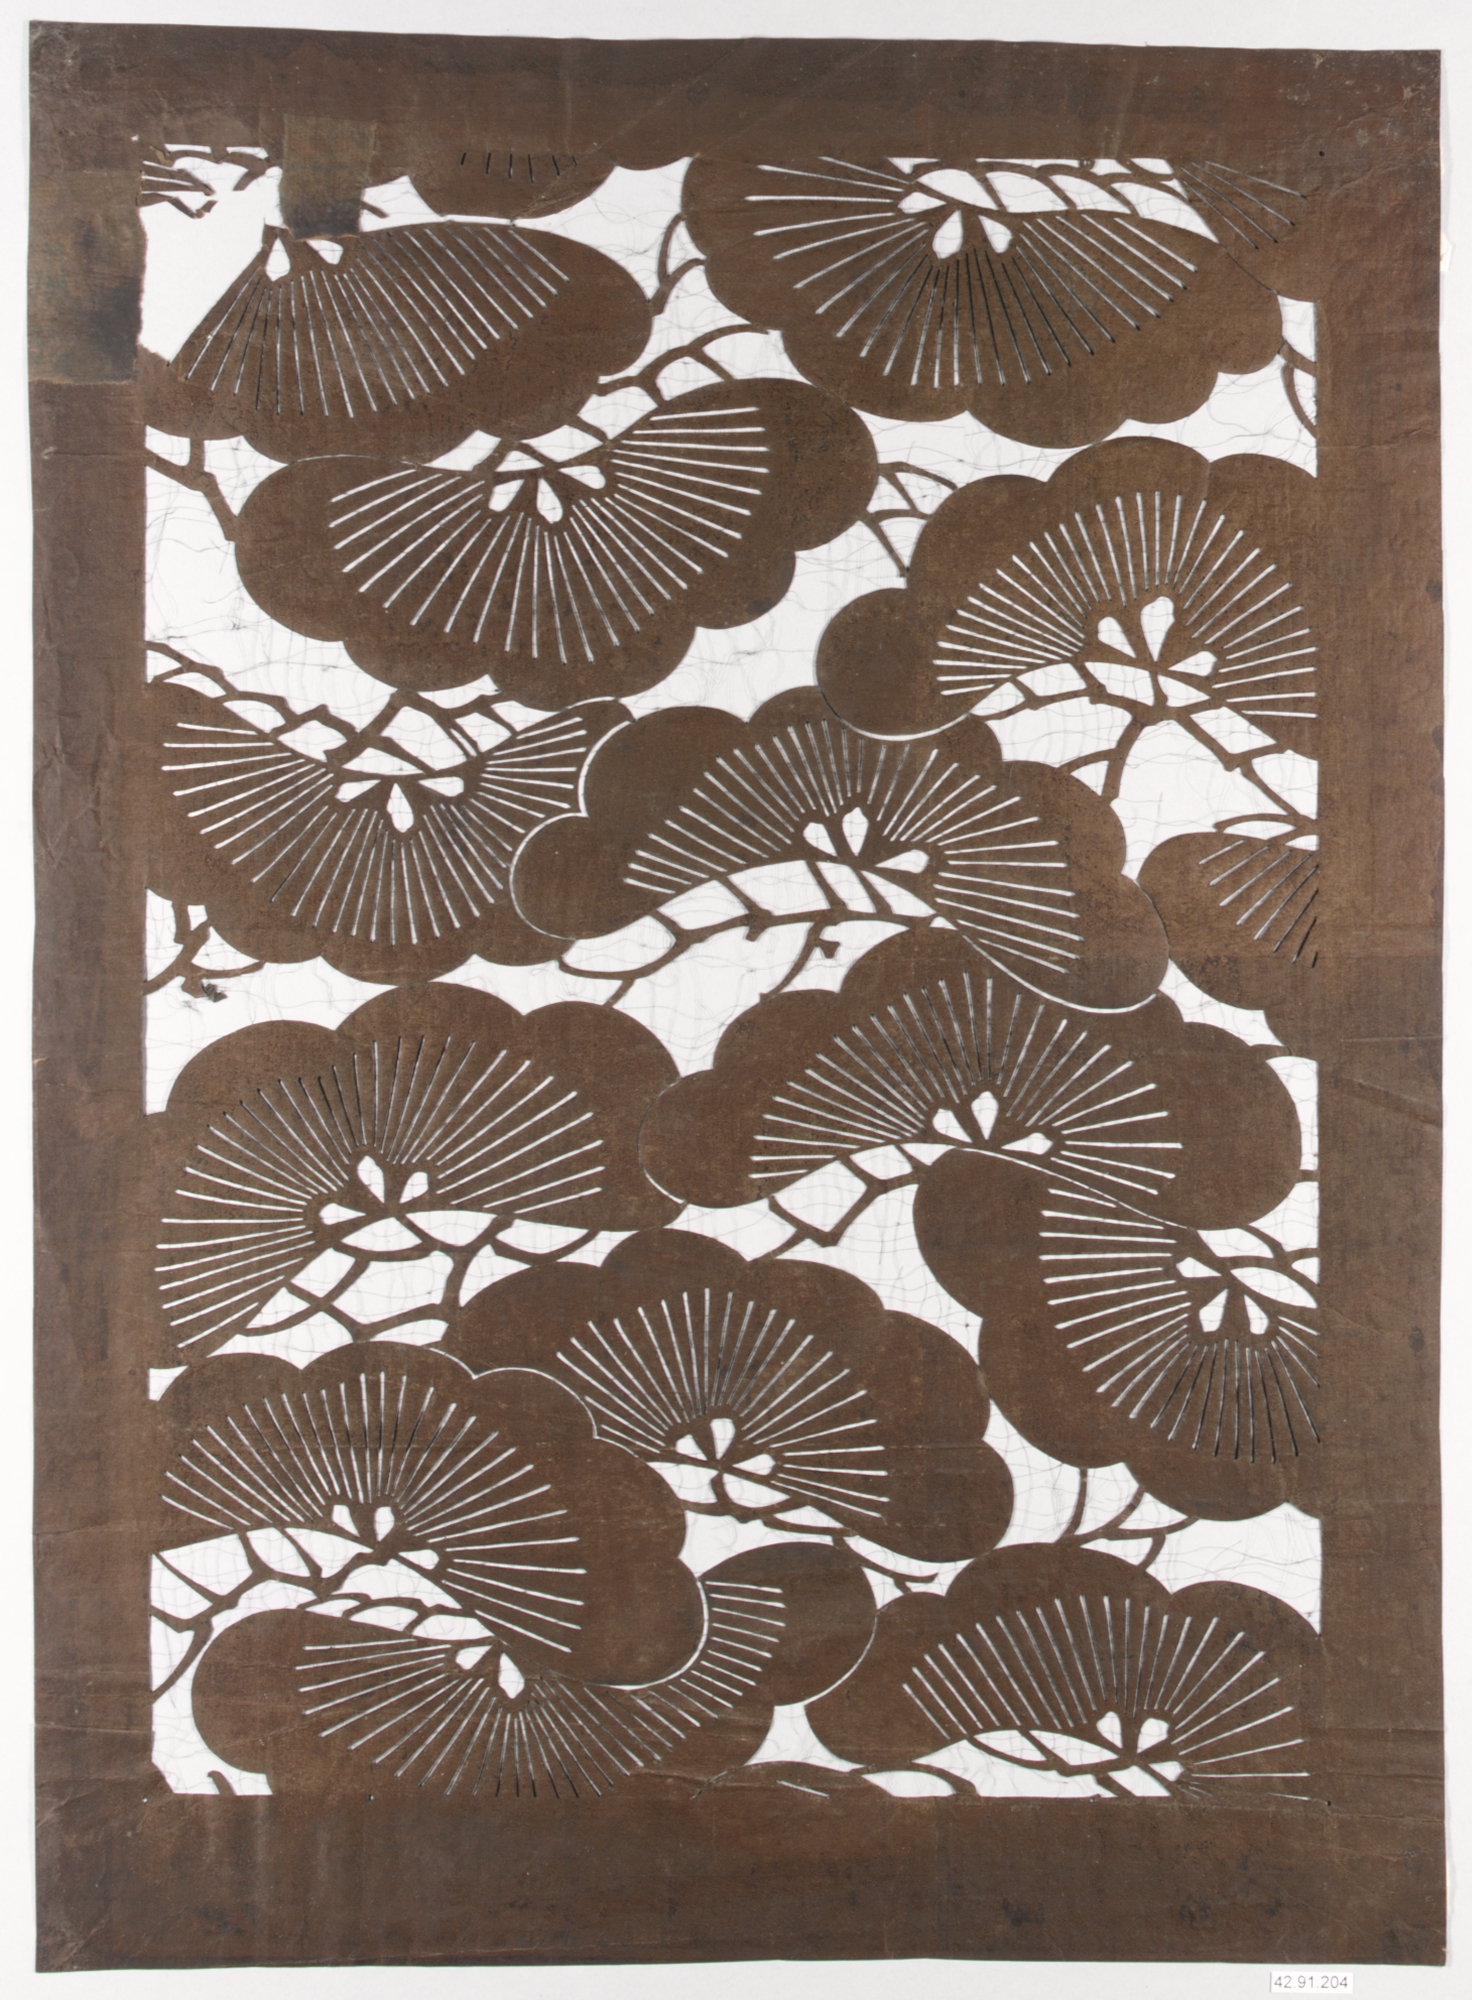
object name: stencil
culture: japanese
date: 1801-1900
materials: paper, silk